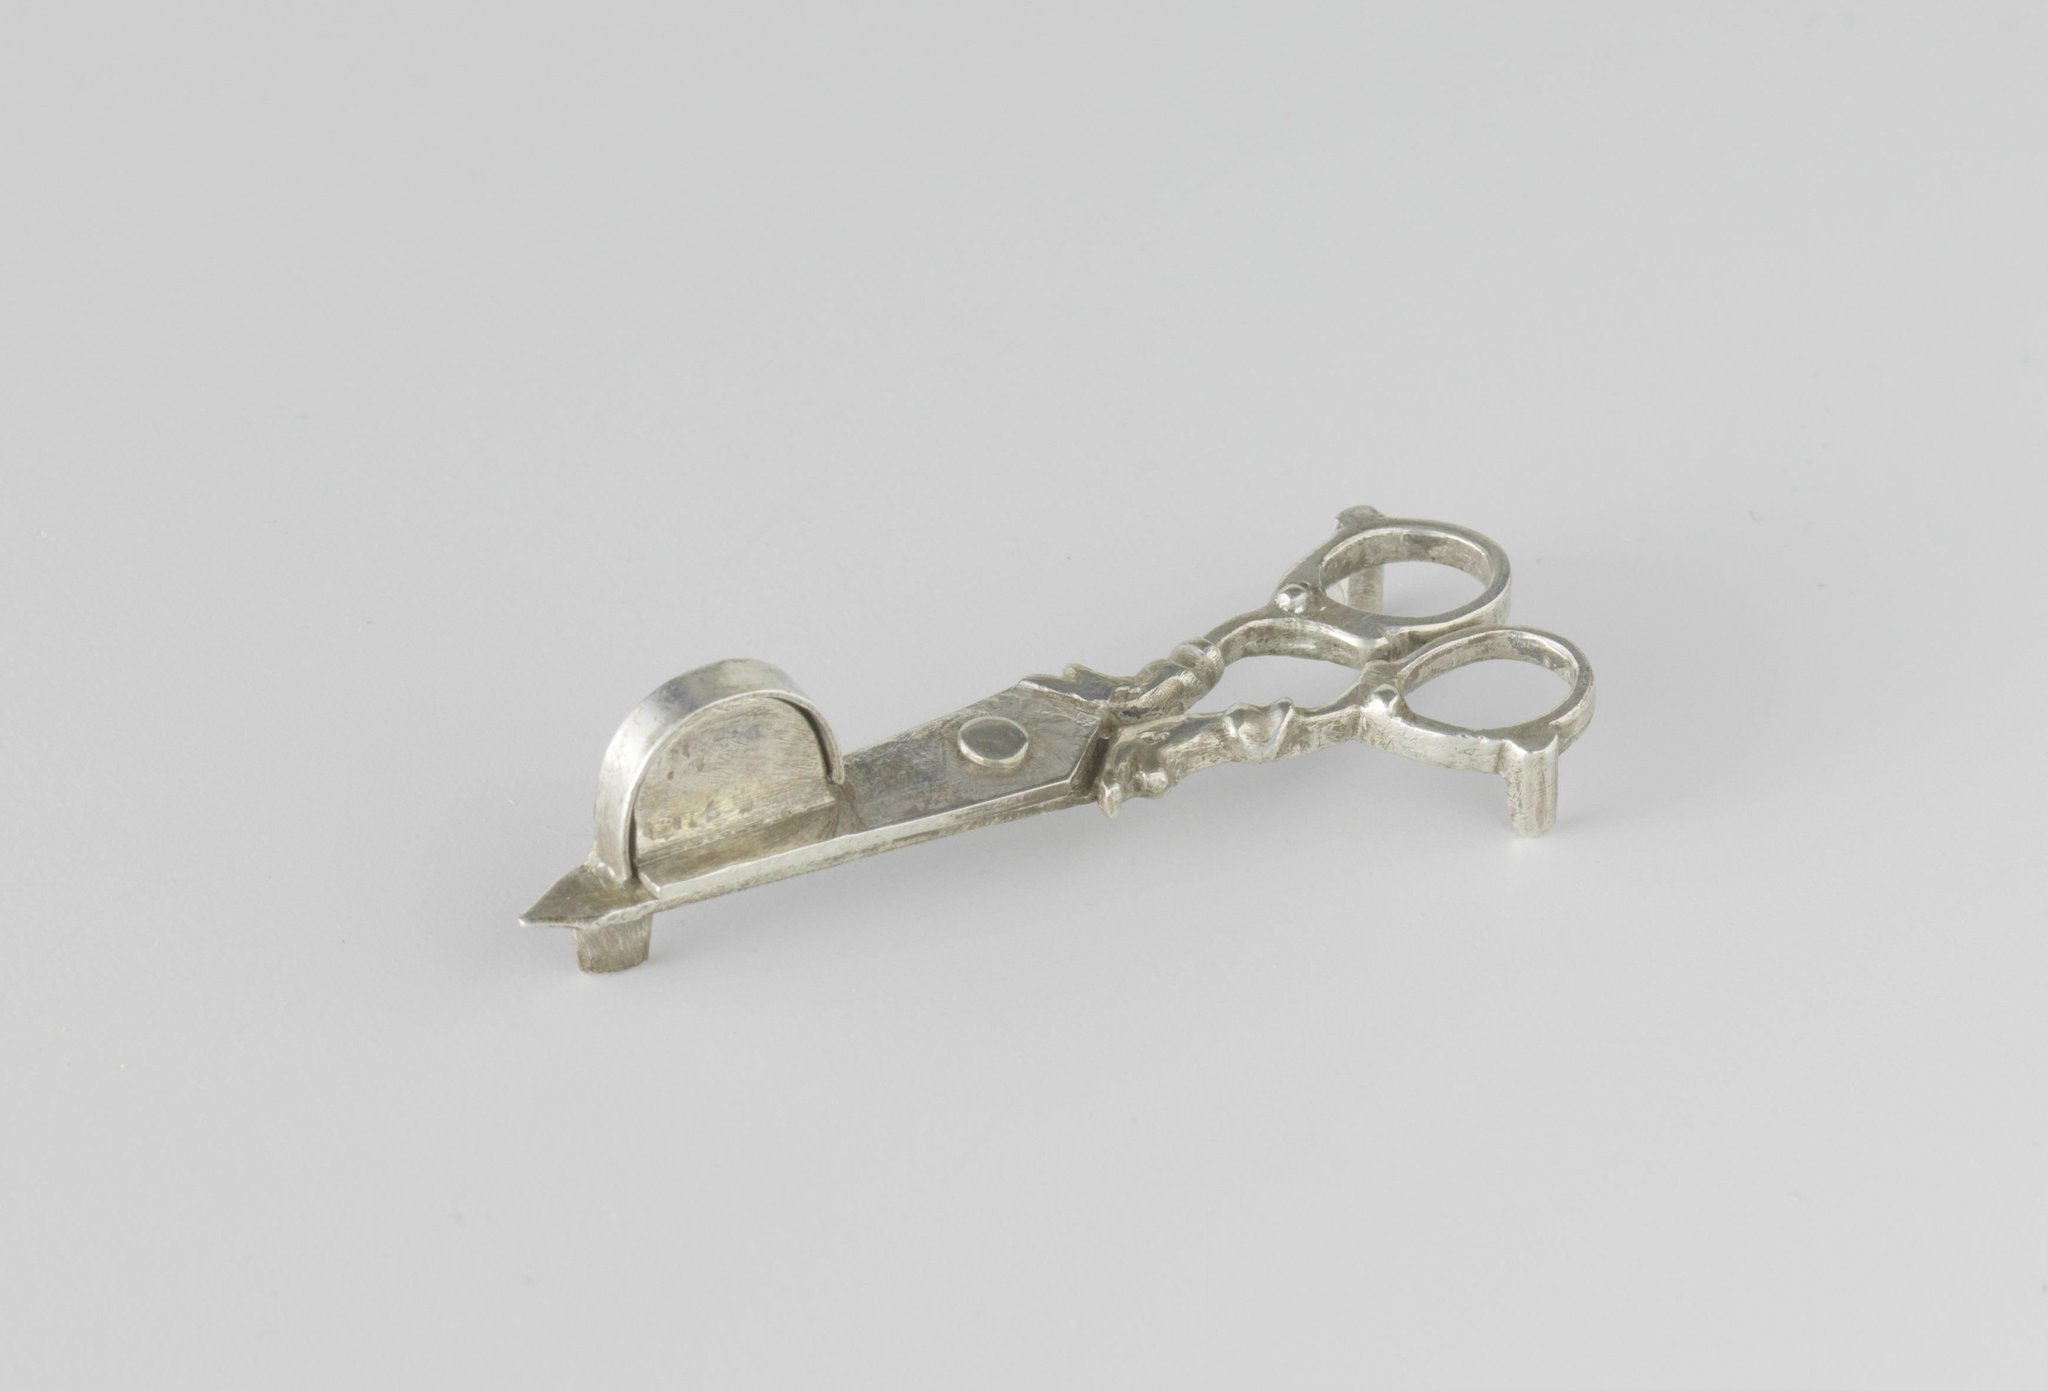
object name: miniature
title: Kaarsensnuiter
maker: Anonymous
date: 1770-1800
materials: silver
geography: amsterdam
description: Kaarsensnuiter staand op drie poten. De handgrepen zijn geprofileerd. De kaarsensnuiter is gemerkt: stk.= Amsterdam een bijltje en twee onleesbare merken.